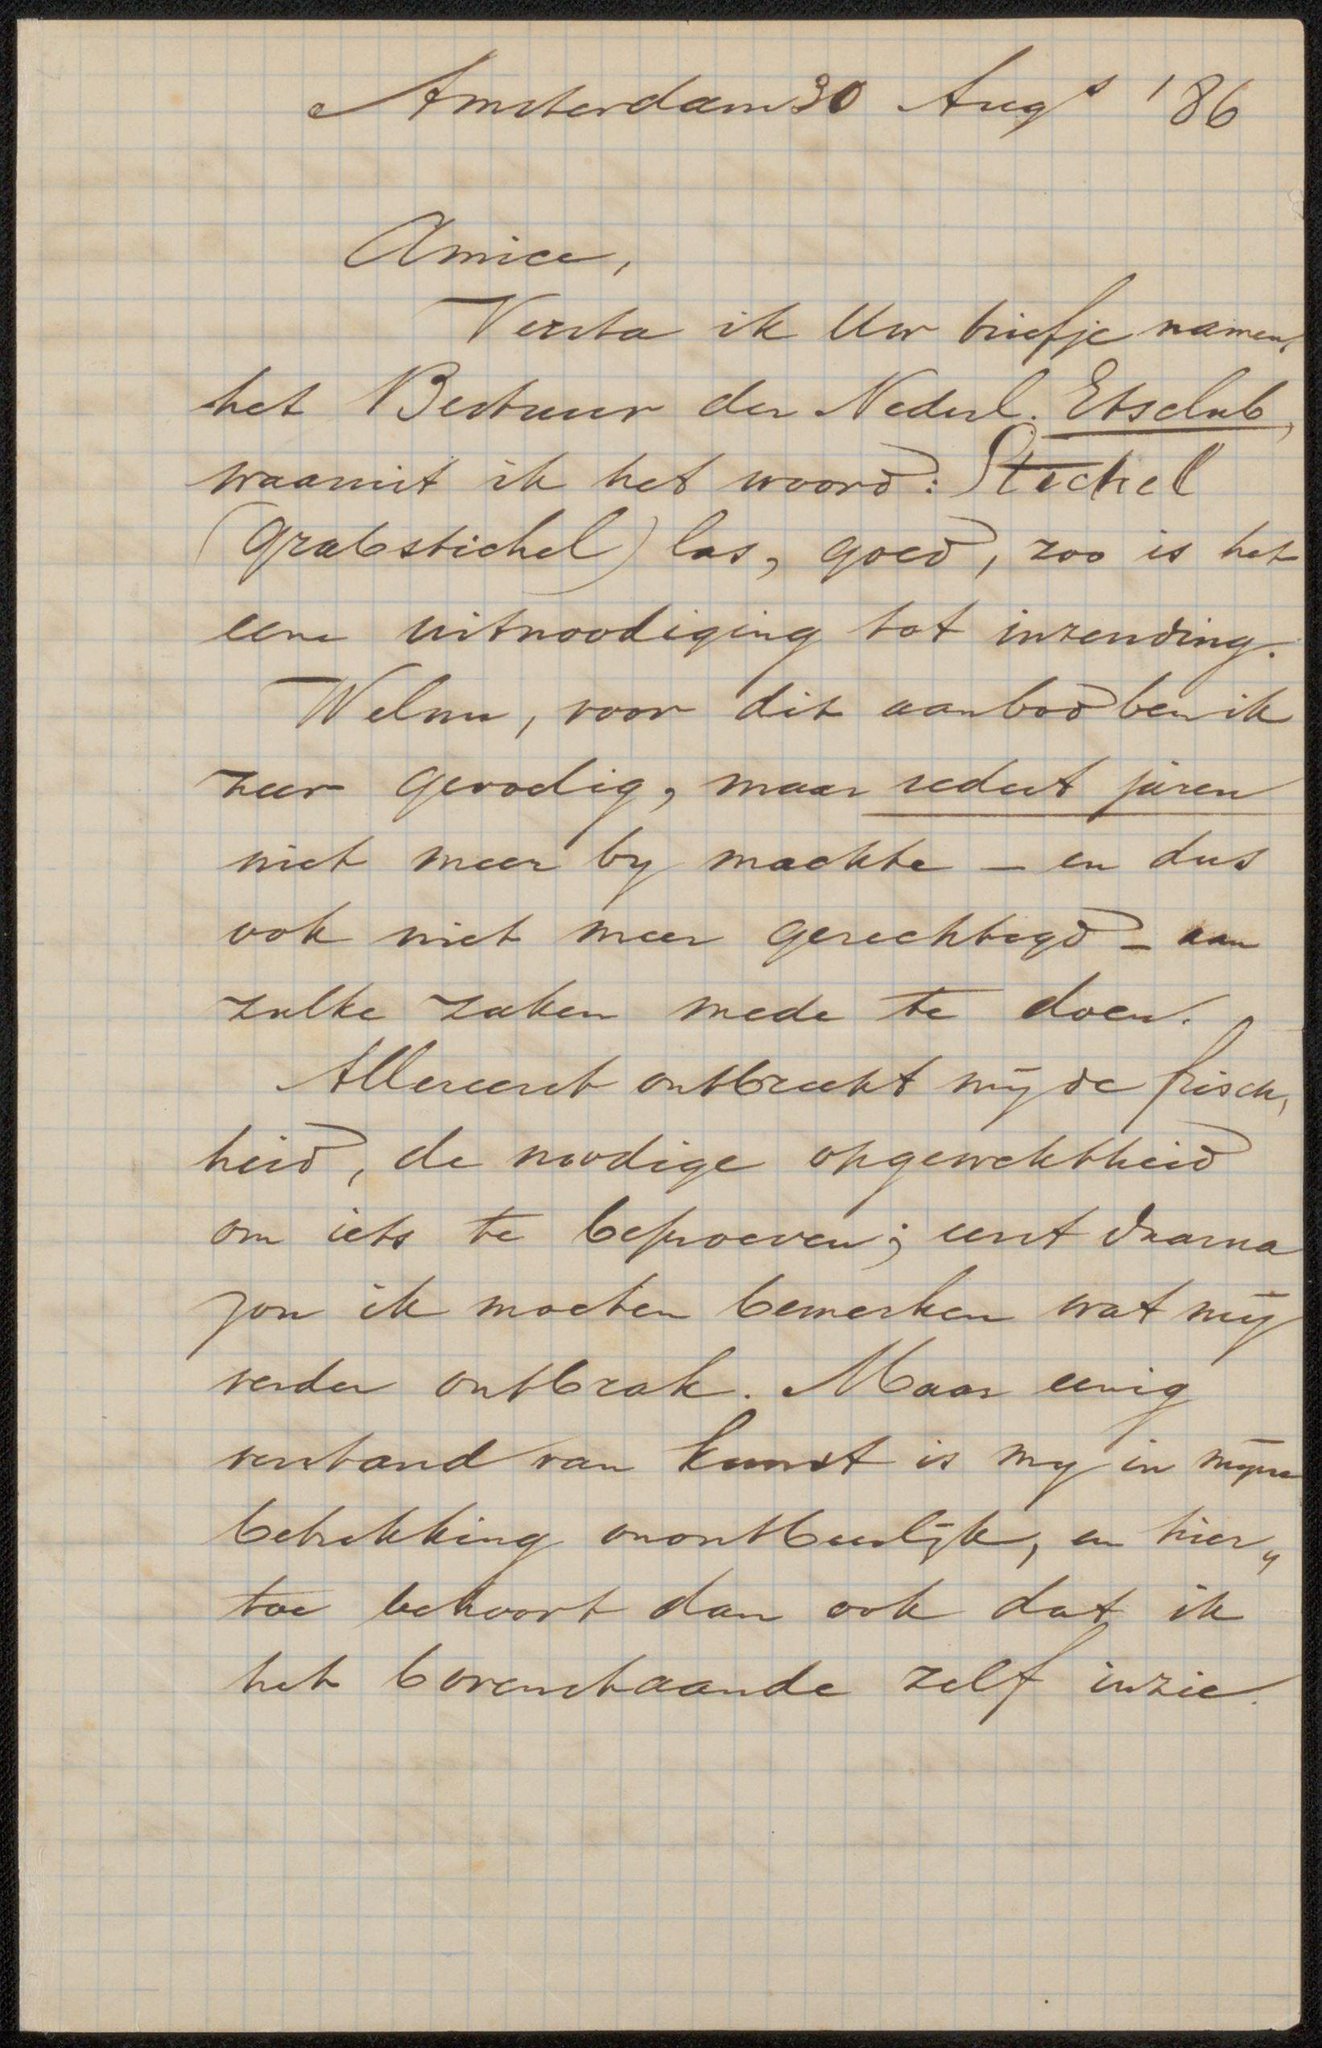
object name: letter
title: Brief aan Jan Veth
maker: august allebé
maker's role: draughtsman, print maker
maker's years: 1838-1927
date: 1886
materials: ink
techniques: pen, writing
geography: amsterdam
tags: hendrik jacobus scholten, dordrecht, amsterdam, painter, print maker, draughtsman, designer, jan veth, nicolaas van der waay, haarlem, jac van looij, wally moes, the hague, hendrik johannes haverman, ernst witkamp, jan van essen, italy, spain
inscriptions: collector's mark: ‘RPK’